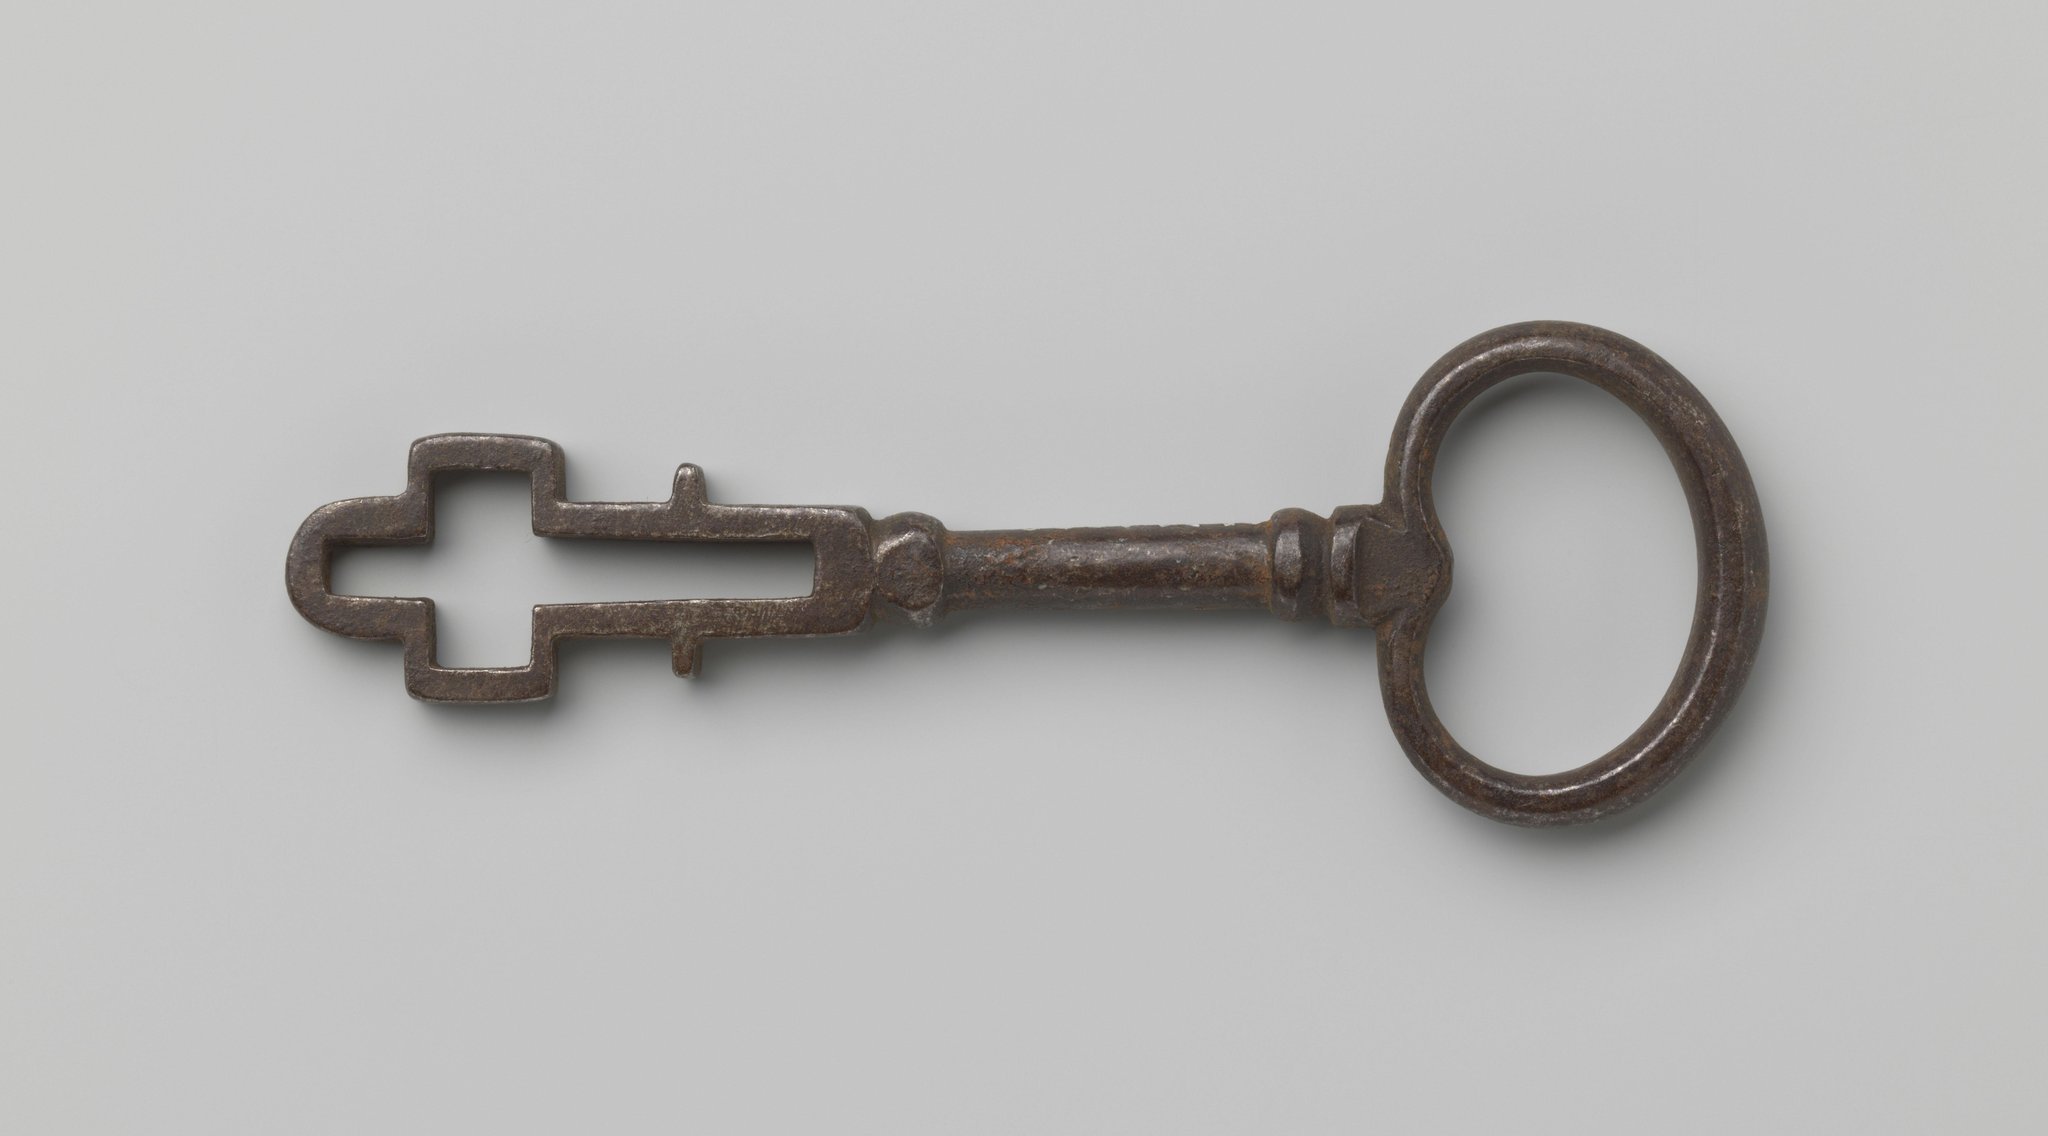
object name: key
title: Sleutel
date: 1400-1950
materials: iron